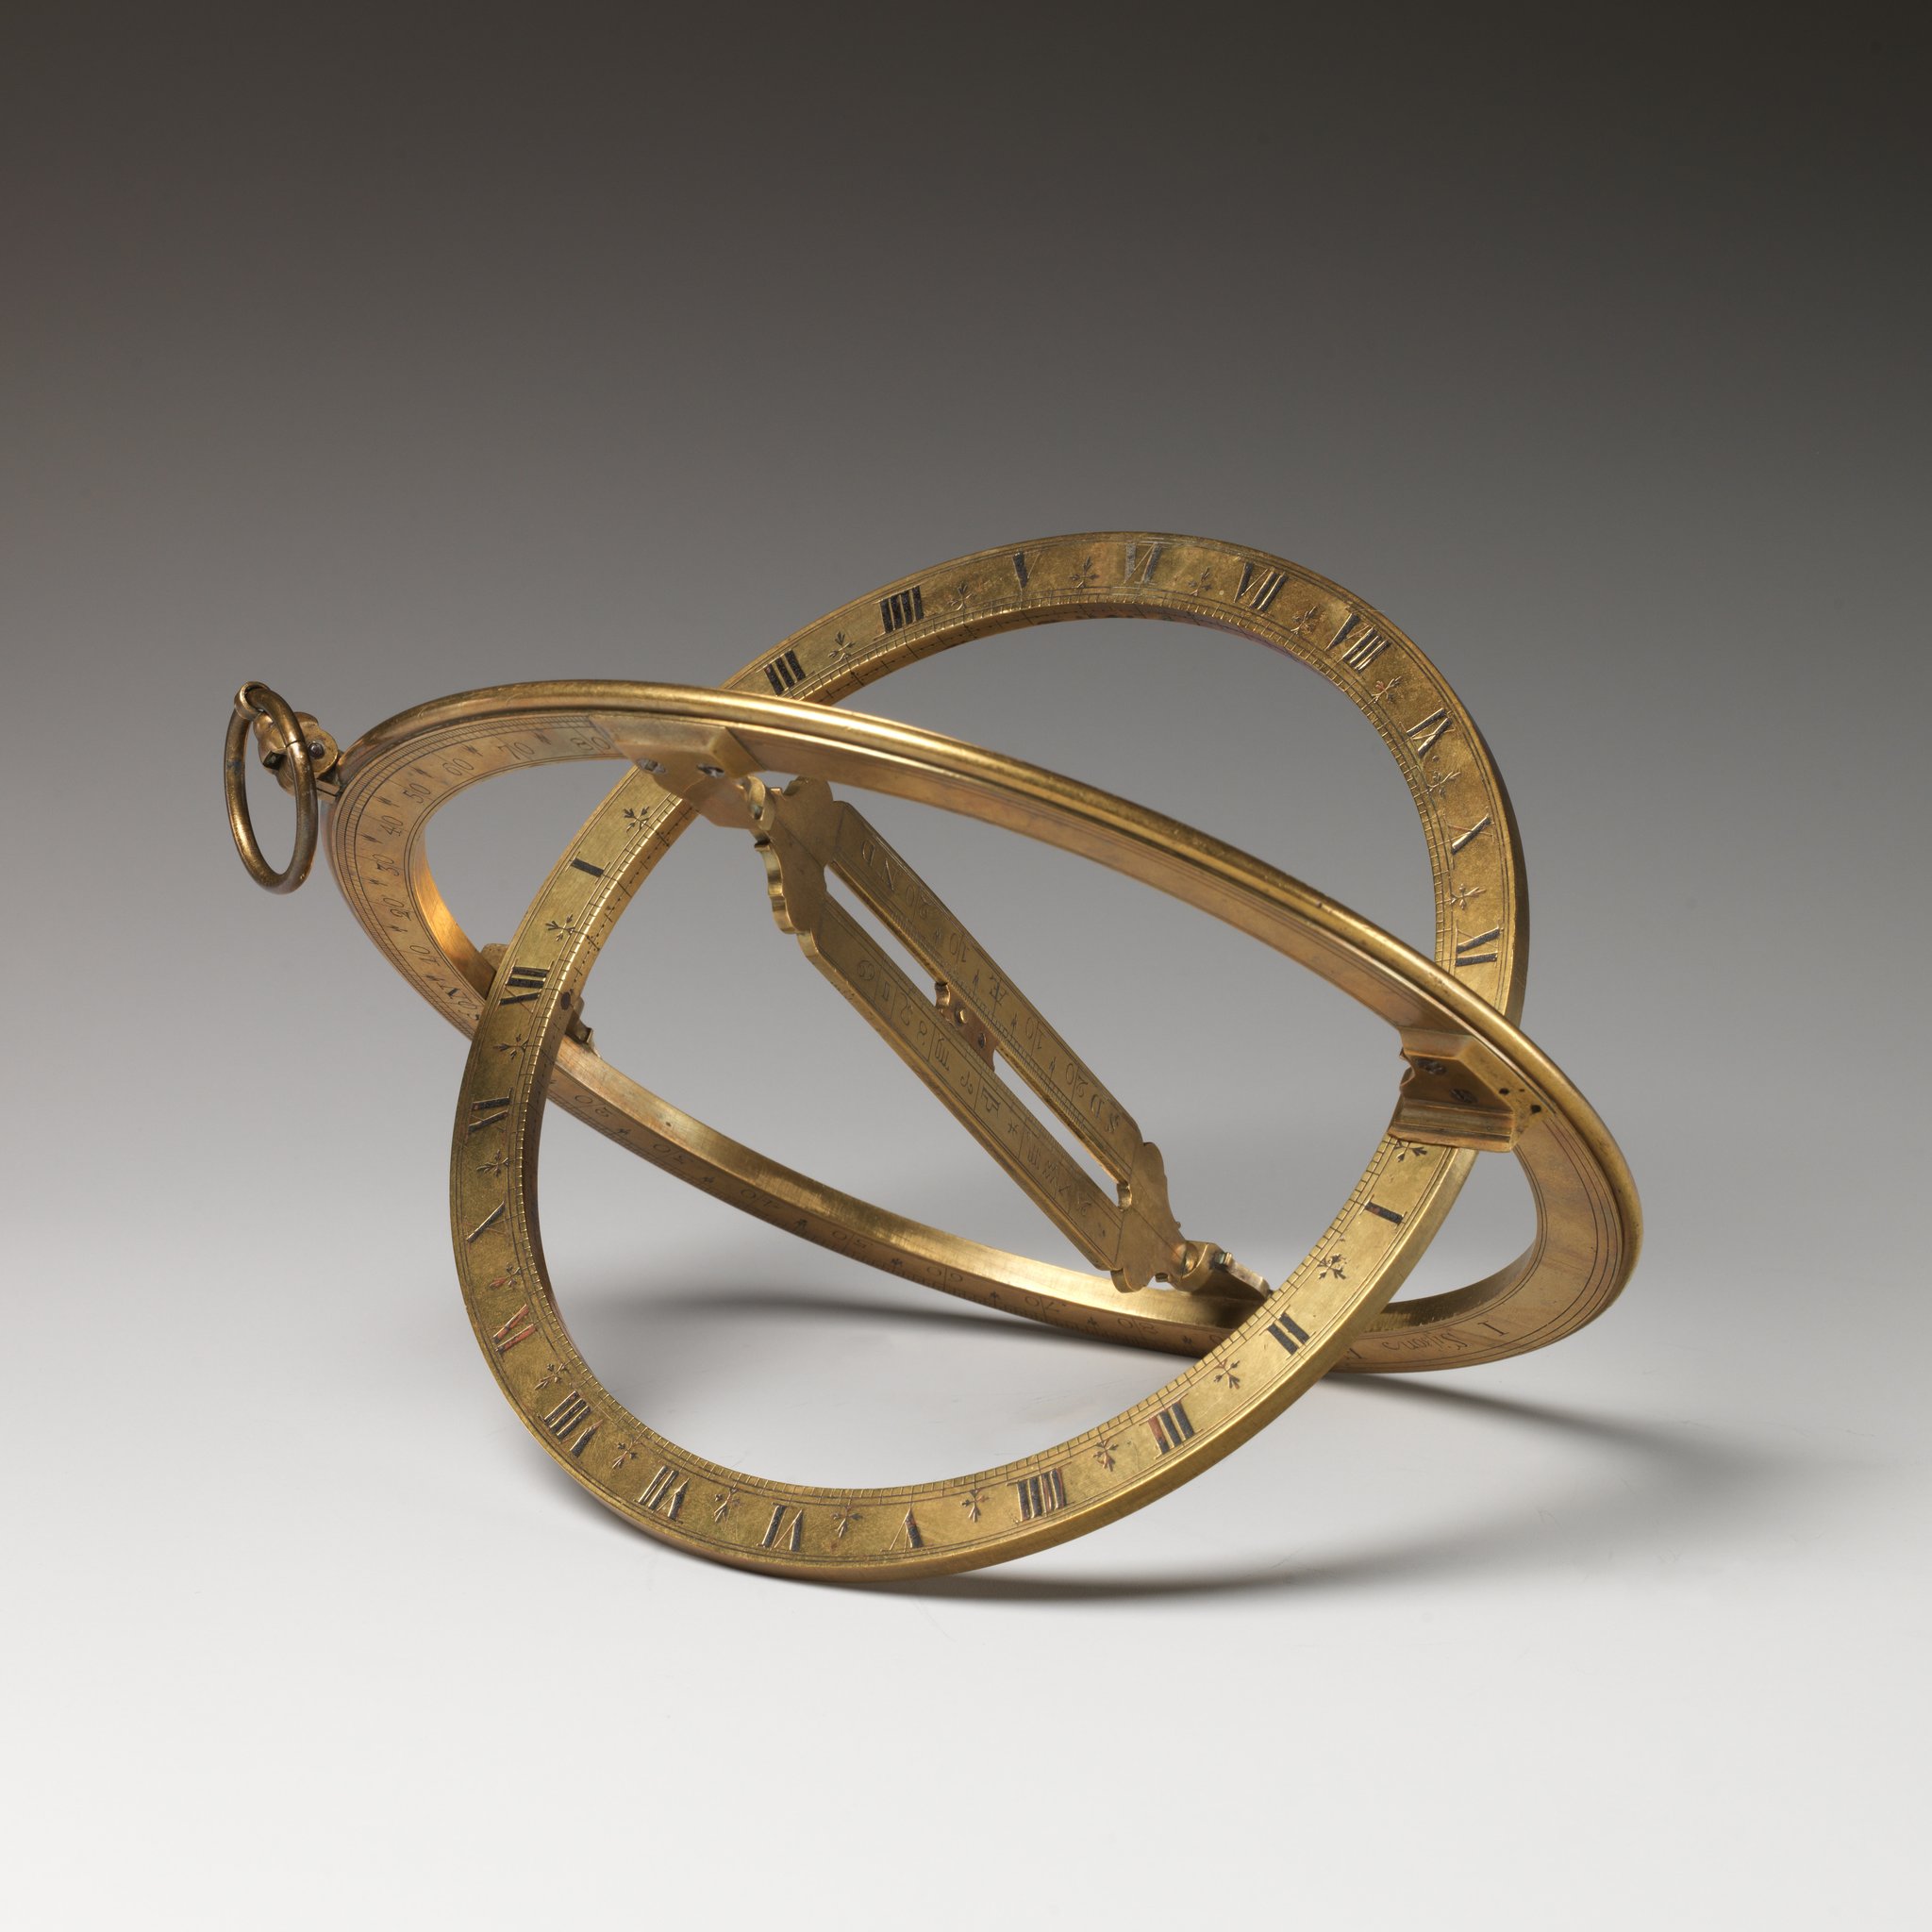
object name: universal ring sundial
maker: jonathan sisson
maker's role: maker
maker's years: 1690-1760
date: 1701-1800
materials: brass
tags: sundials